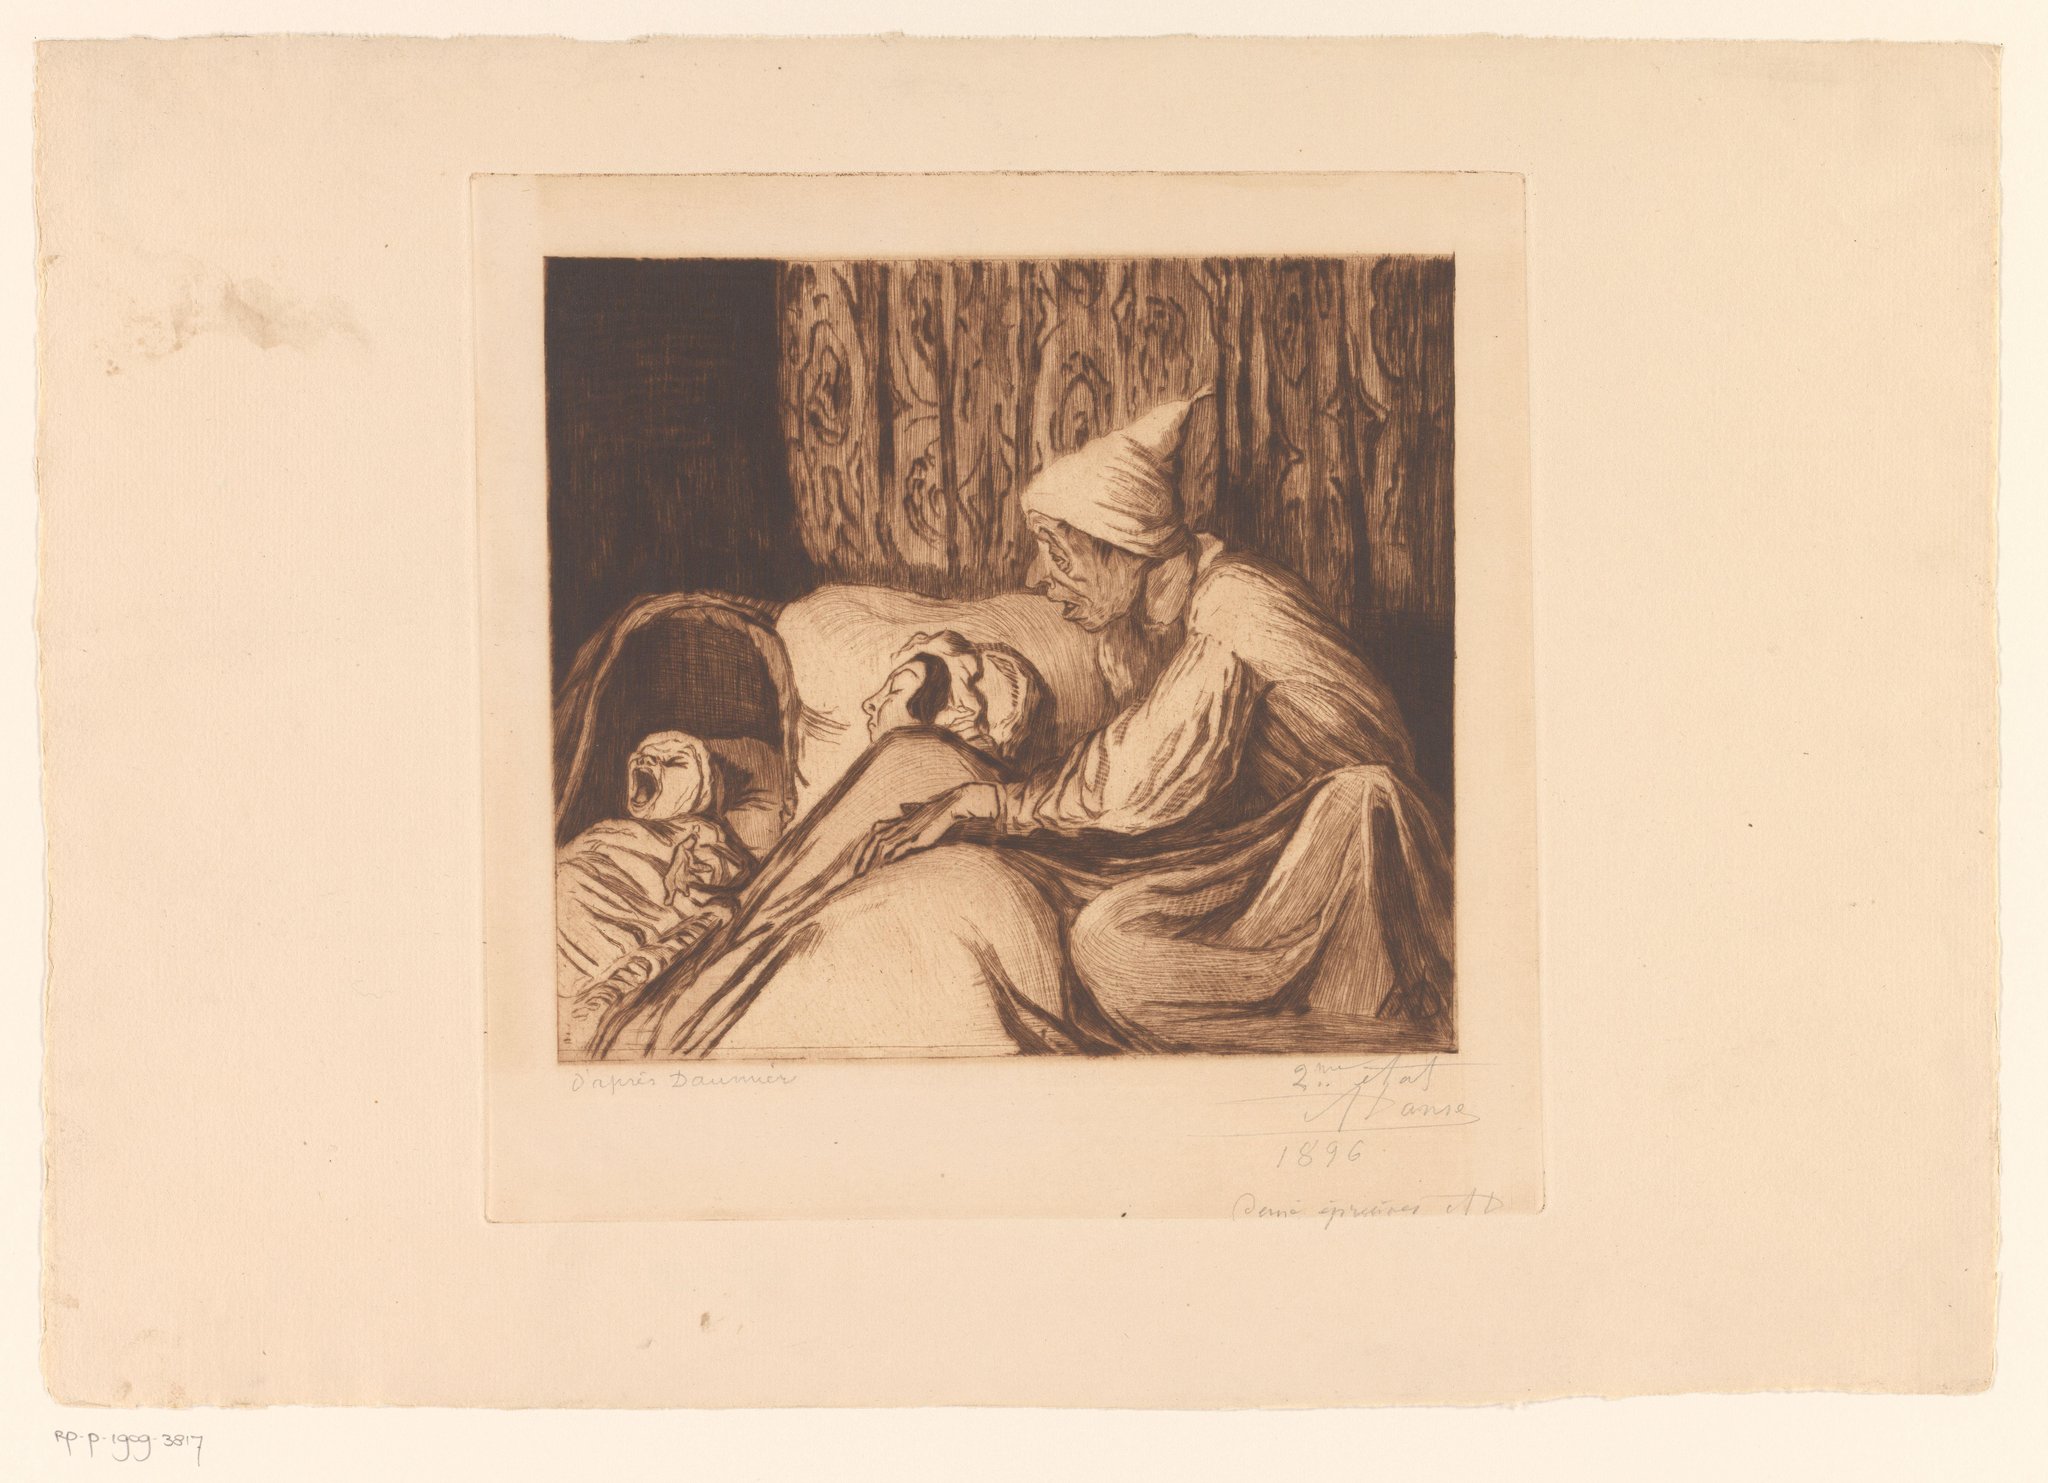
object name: print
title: Baby in bed bij de ouders huilt vader wakker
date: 1896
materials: paper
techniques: drypoint, etching, intaglio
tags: hearing, listening (one of the five senses), waking up, watching a sleeping child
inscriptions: collector's mark: Lugt 2228, annotation: ‘2me etat; deux épreuves’